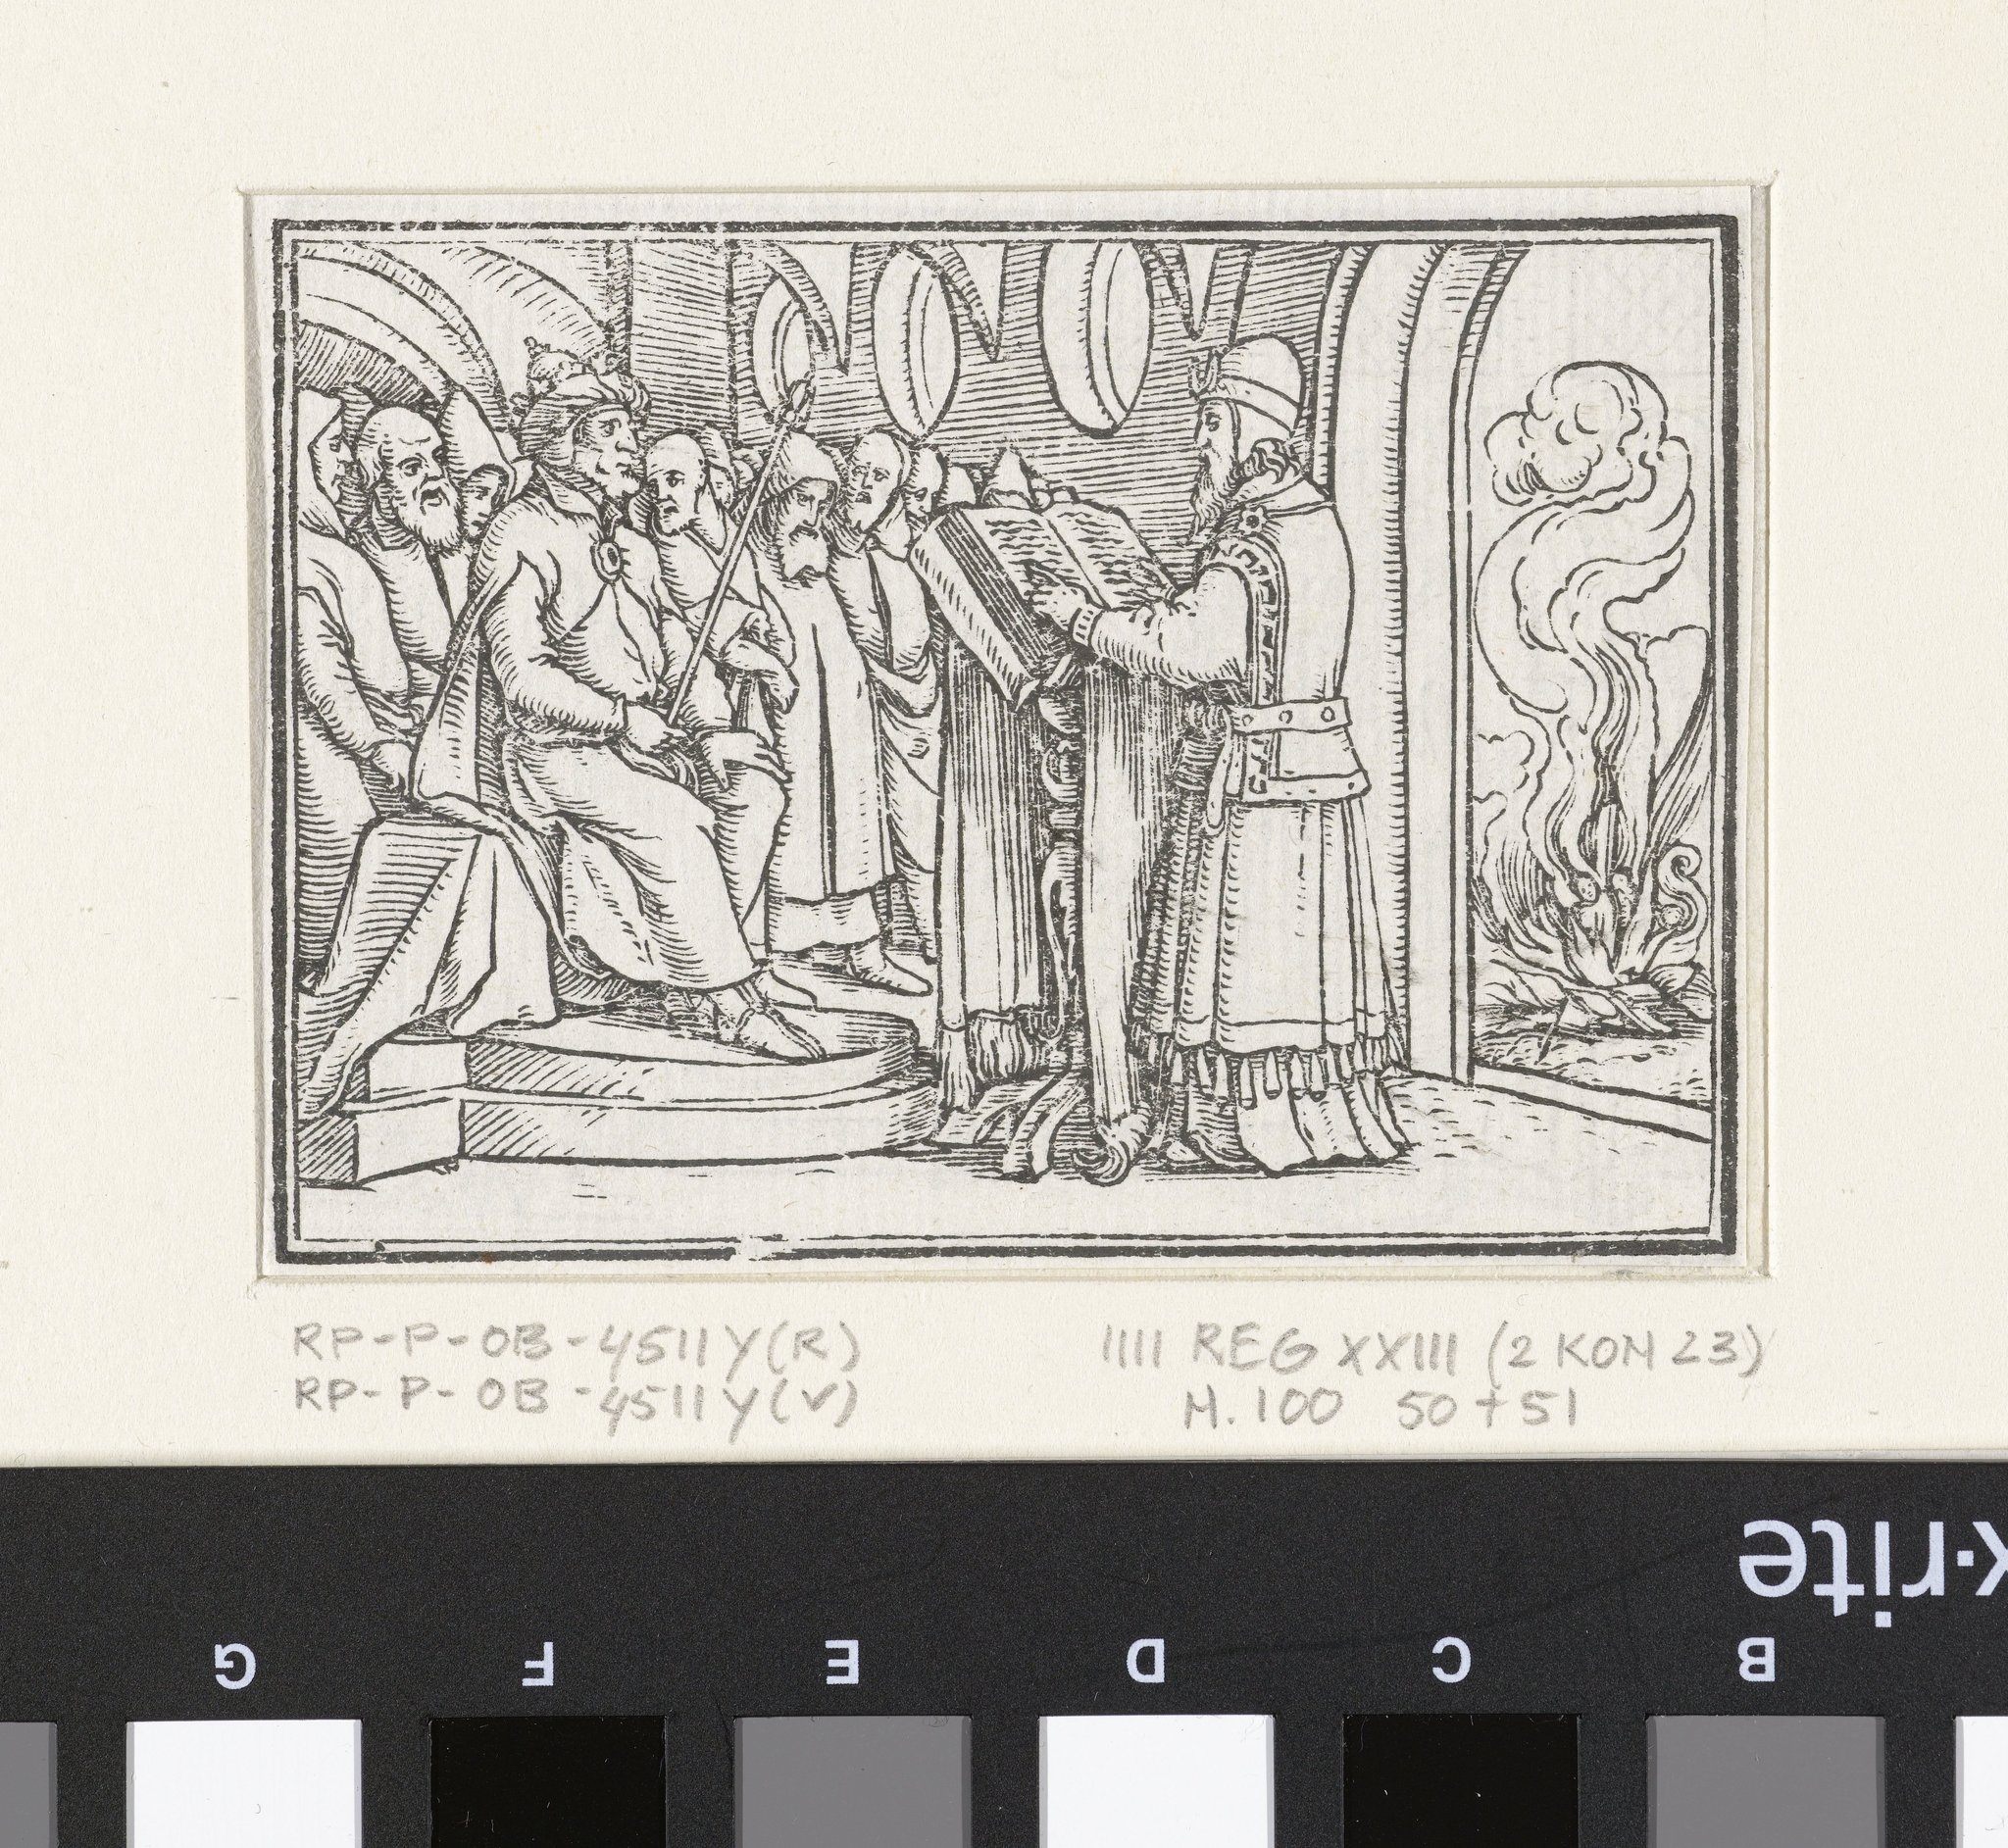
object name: print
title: Chilkia leest de wetten voor aan koning Josia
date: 1538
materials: paper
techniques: woodcut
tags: saphan reads the book of law aloud to the king who tears his clothes in dismay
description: De hogepriester Chilkia staat rechts bij een lezenaar en leest de wetten voor aan koning Josia die links op een troon zit in de tempel. Achter de koning staat de bevolking en de priesters van Juda en Jeruzalem. Buiten brandt een vuur waarin alle heidense offers worden verbrand die in de tempel werden gevonden. In de marge boven de afbeelding staat de tekst IIII Regvm XXIII [2 Koningen 23].